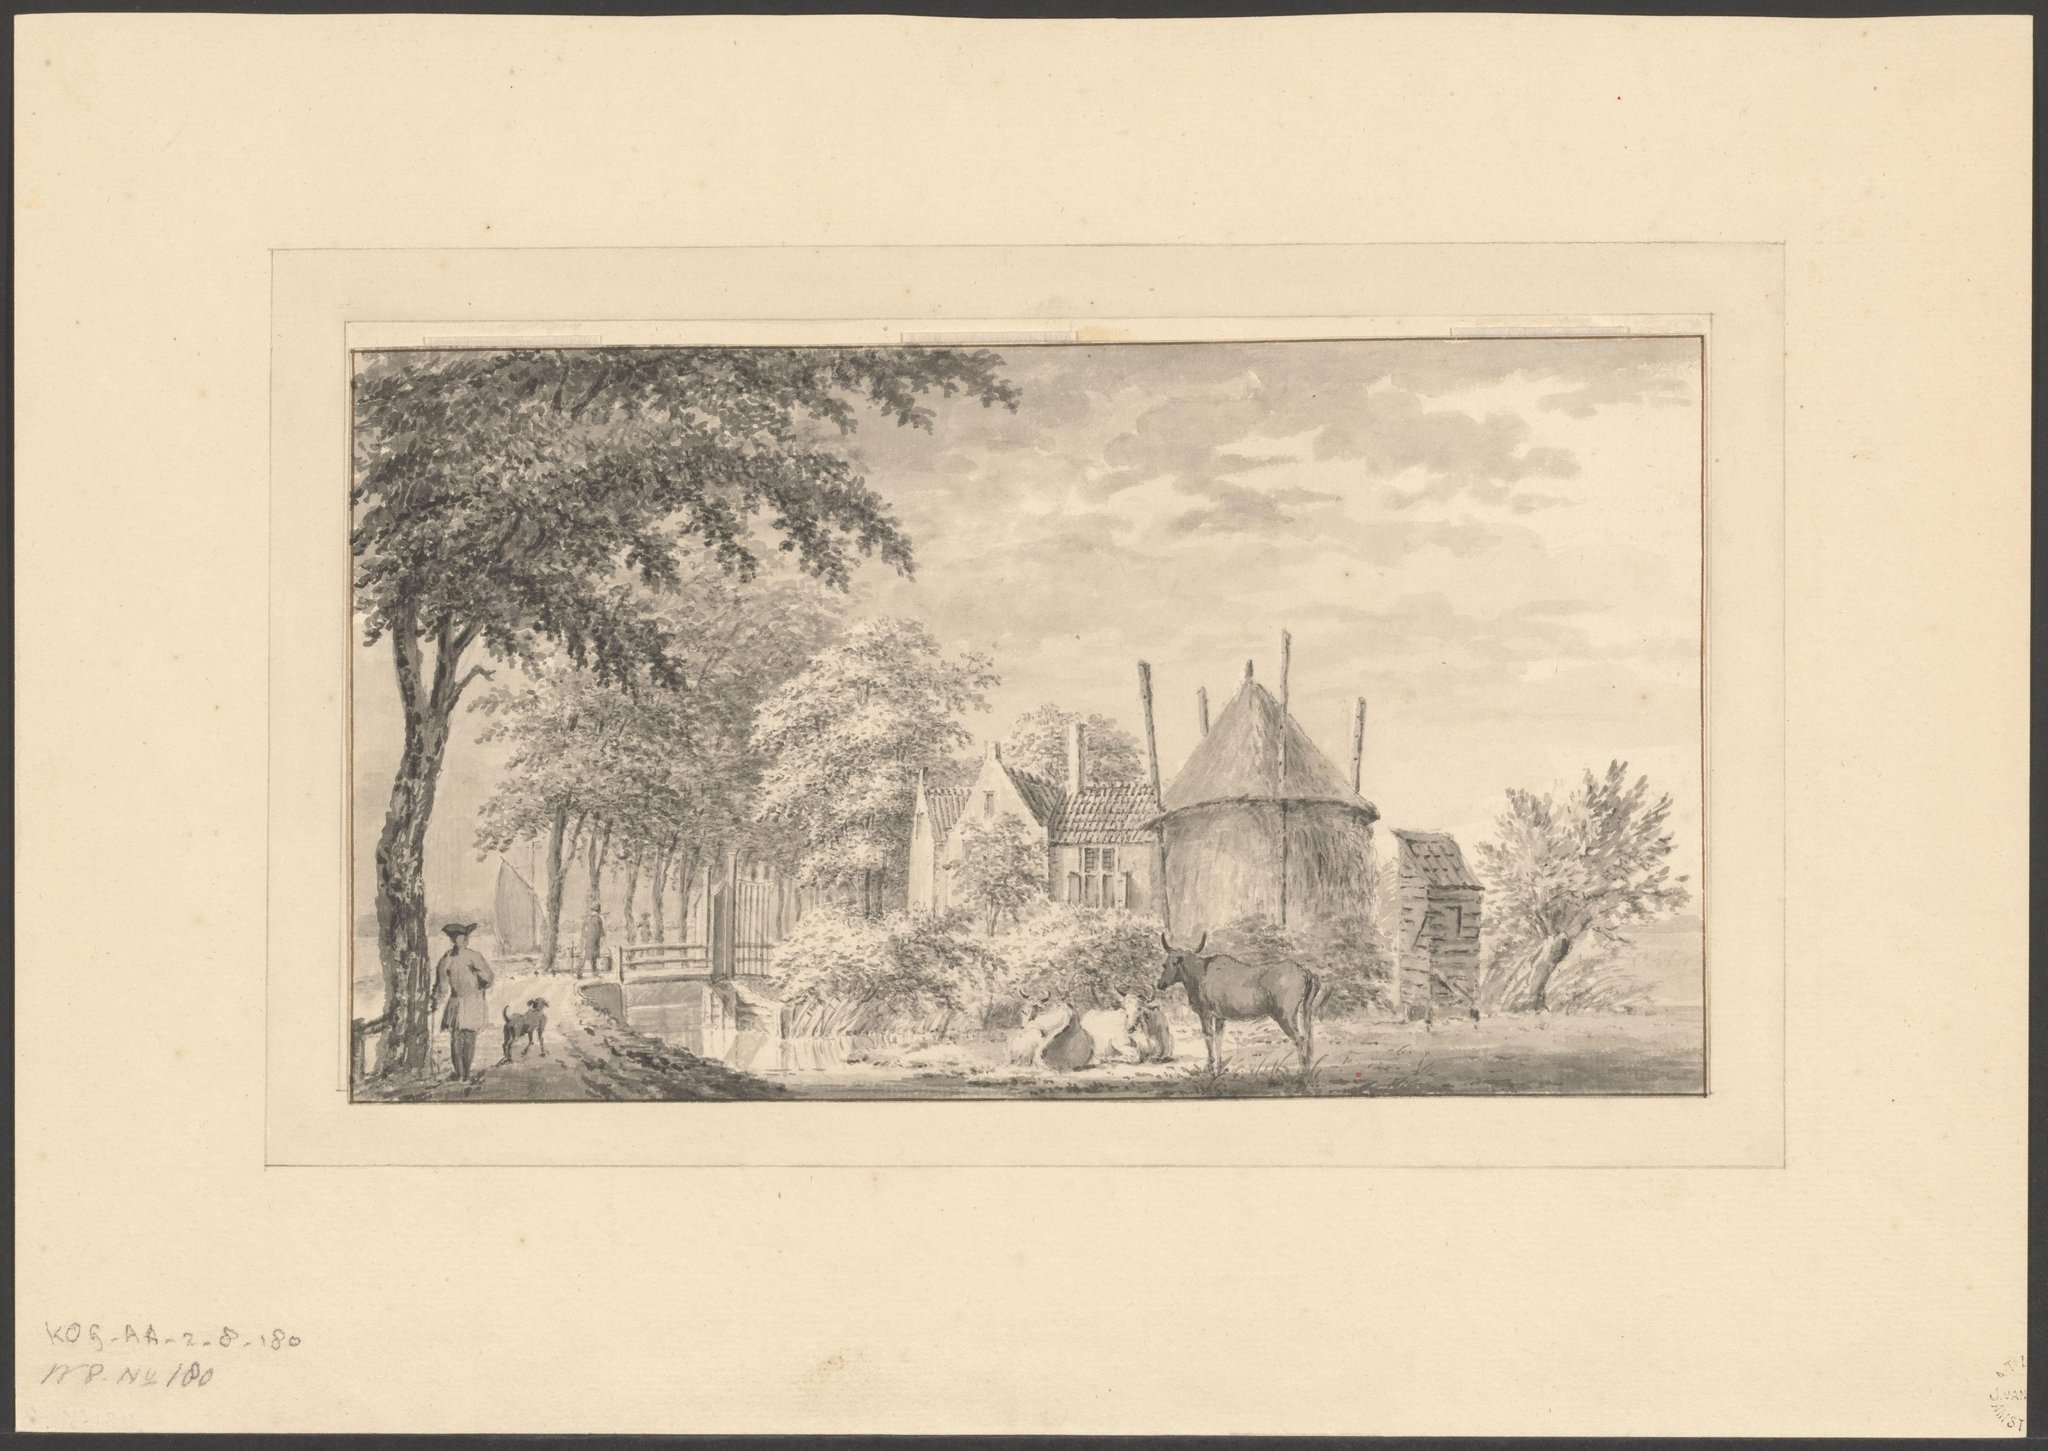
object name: drawing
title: Gezicht op een boerderij aan de Buiten-Amstel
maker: Anonymous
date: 1700-1799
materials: ink, paper, pencil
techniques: brush, snipping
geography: amsterdam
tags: city-view in general; 'veduta', river, bovine cattle, farm or solitary house in landscape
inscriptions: collector's mark: Lugt 800a, inscription: ‘aan den Amstel’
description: Tekening binnen de Atlas Van Eck ingedeeld op wijknummer 8.